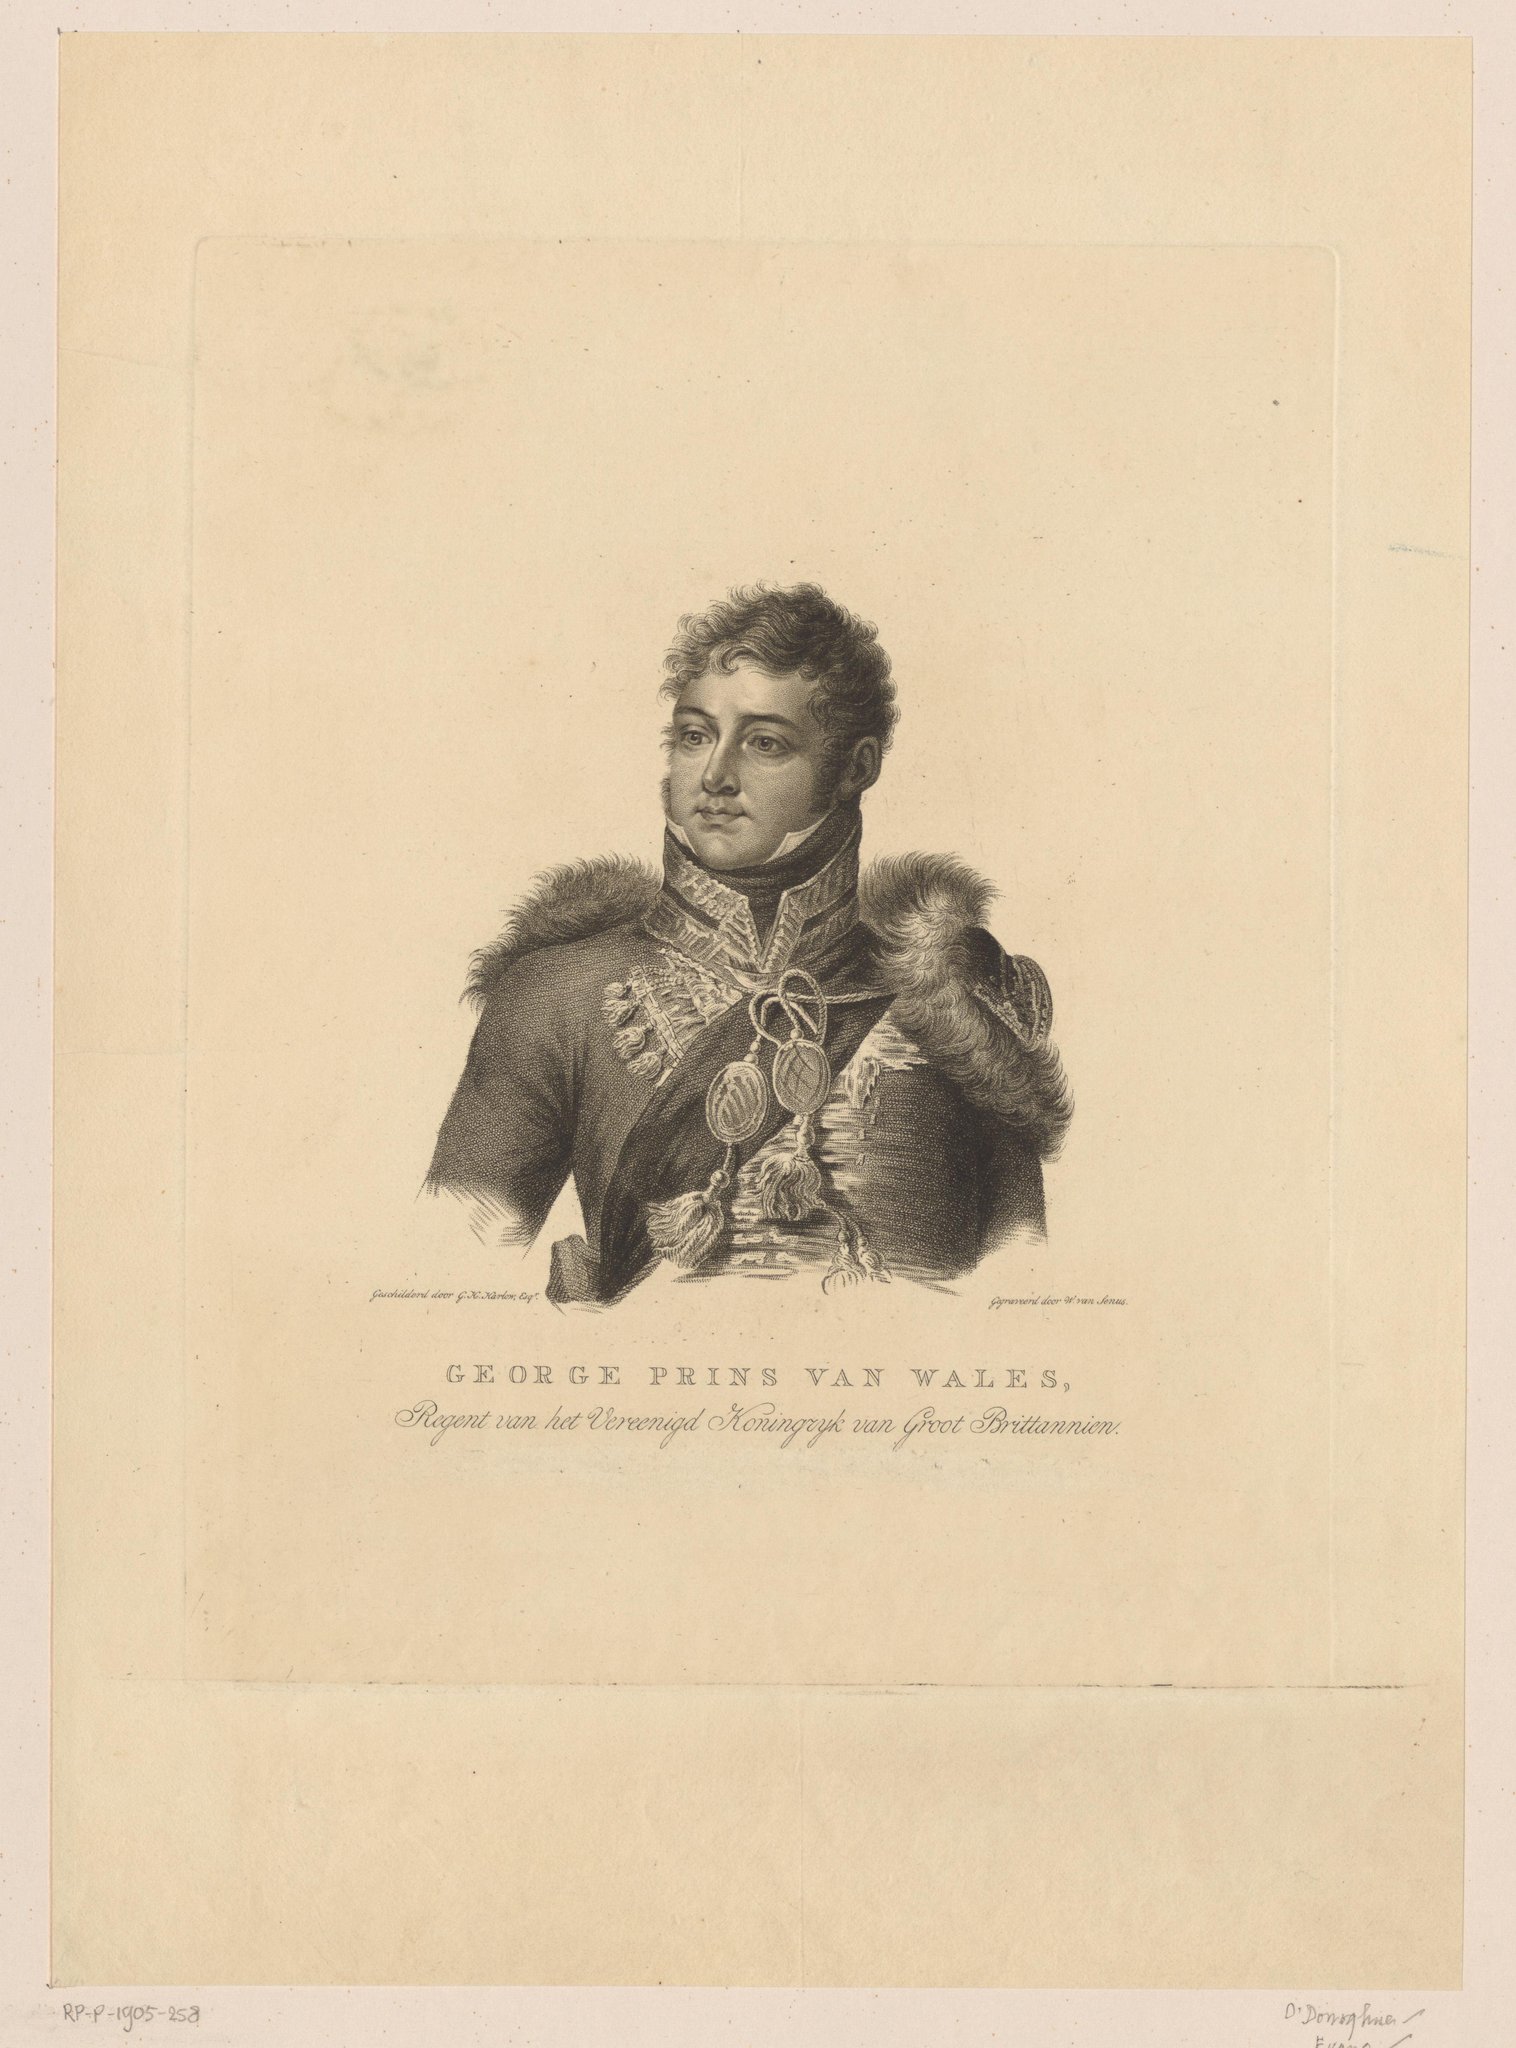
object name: print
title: Portret van George IV, koning van het Verenigd Koninkrijk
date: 1811-1820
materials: paper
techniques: engraving, roulette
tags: george iv (koning van het verenigd koninkrijk), historical persons, king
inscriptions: collector's mark: Lugt 2228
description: Het portret is gemaakt toen George nog prins van Wales was.